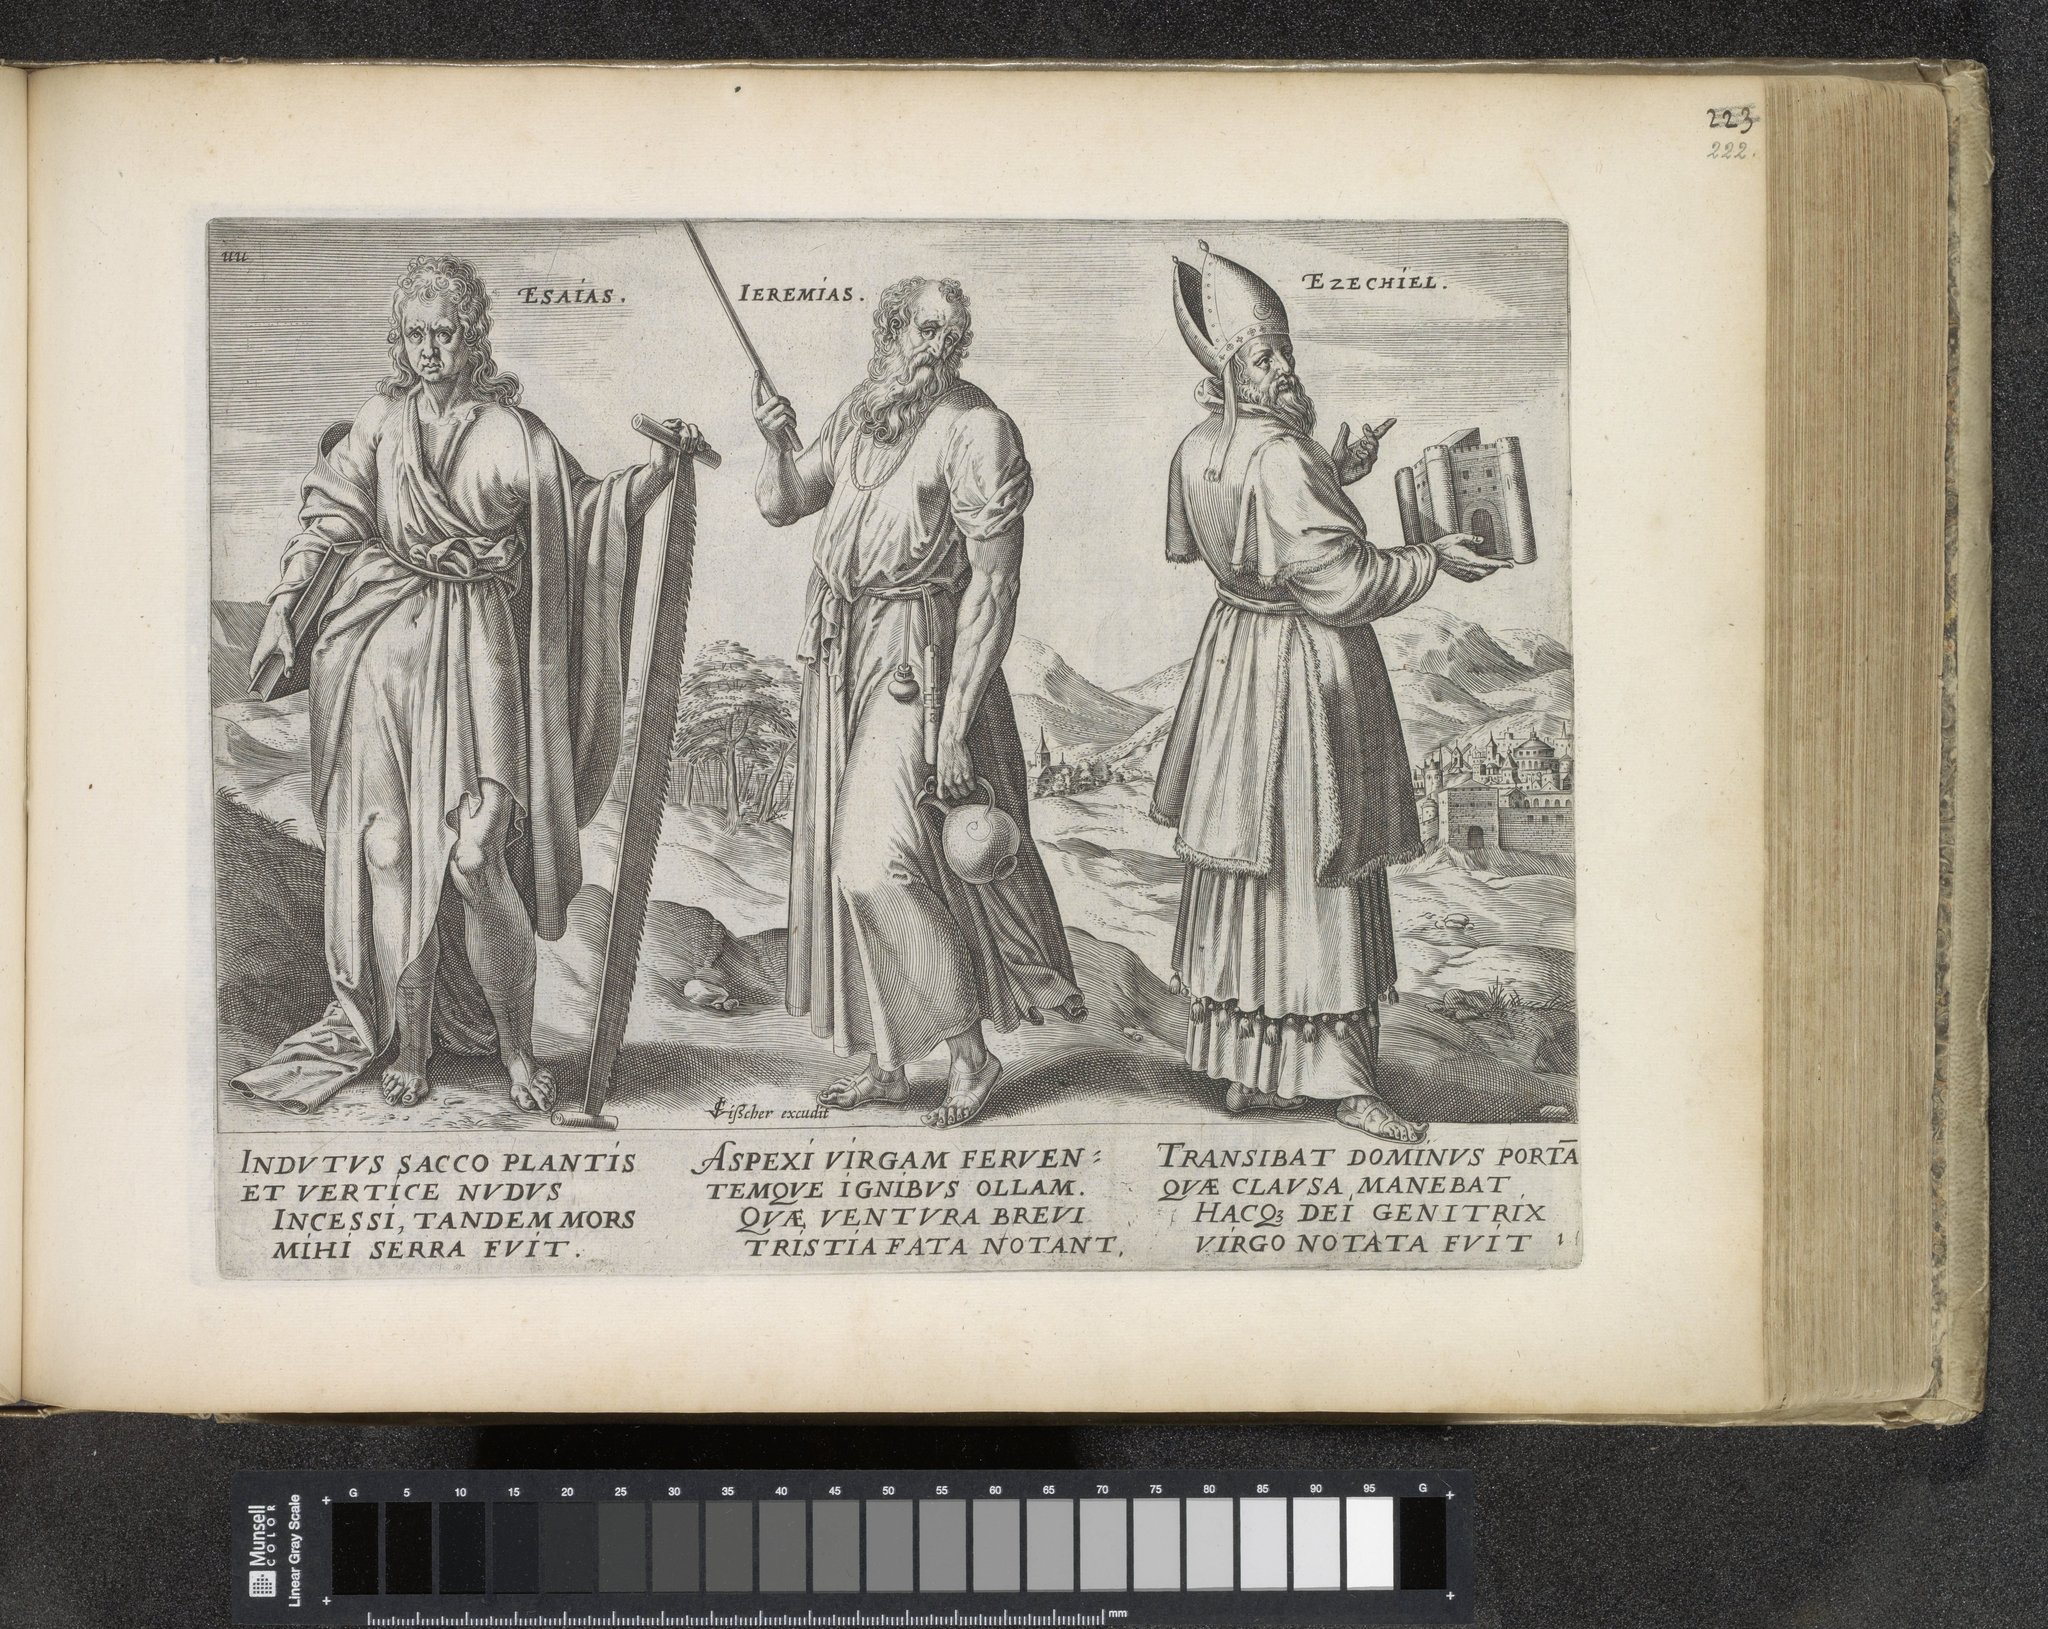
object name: print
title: Twaalf profeten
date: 1579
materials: paper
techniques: engraving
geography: amsterdam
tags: the four major prophets (not in biblical context): isaiah, jeremiah, ezekiel, daniel, jeremiah (not in biblical context); possible attributes: book or scroll, 'the seething pot', isaiah (not in biblical context); possible attributes: branch with leaves, saw, scroll or book, ezekiel (not in biblical context); possible attributes: book or scroll, double wheel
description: De profeten Jesaja, Jeremia en Ezechiël staan naast elkaar in een landschap. Jesaja houdt een boek onder de arm en houdt een zaag in zijn hand, Jeremia houdt een staf en kruik in de handen, Ezechiël houdt de tempel in zijn hand, die hij in een visioen zag. Onder de voorstelling toelichtingen in het Latijn. Deze prent maakt deel uit van een album.